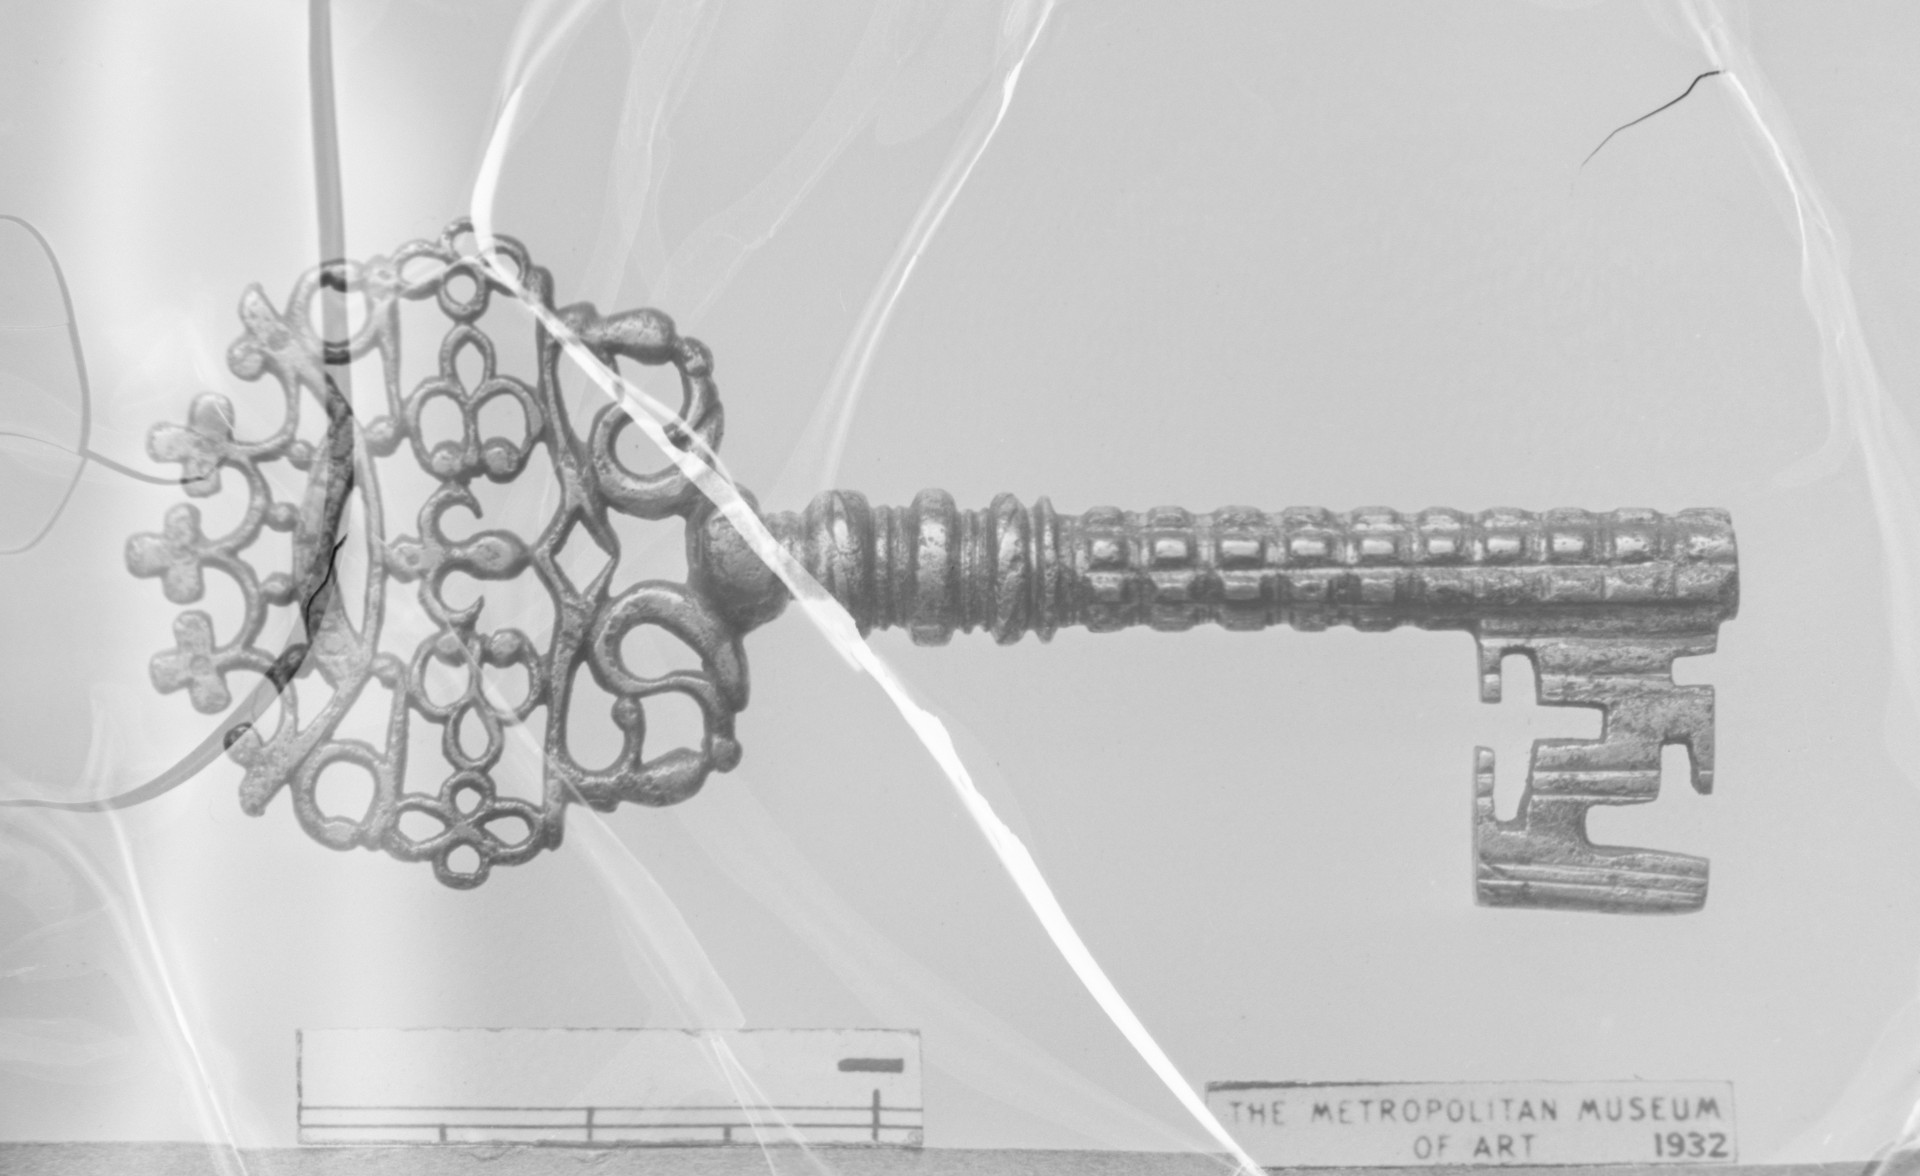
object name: key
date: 1601-1700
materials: iron